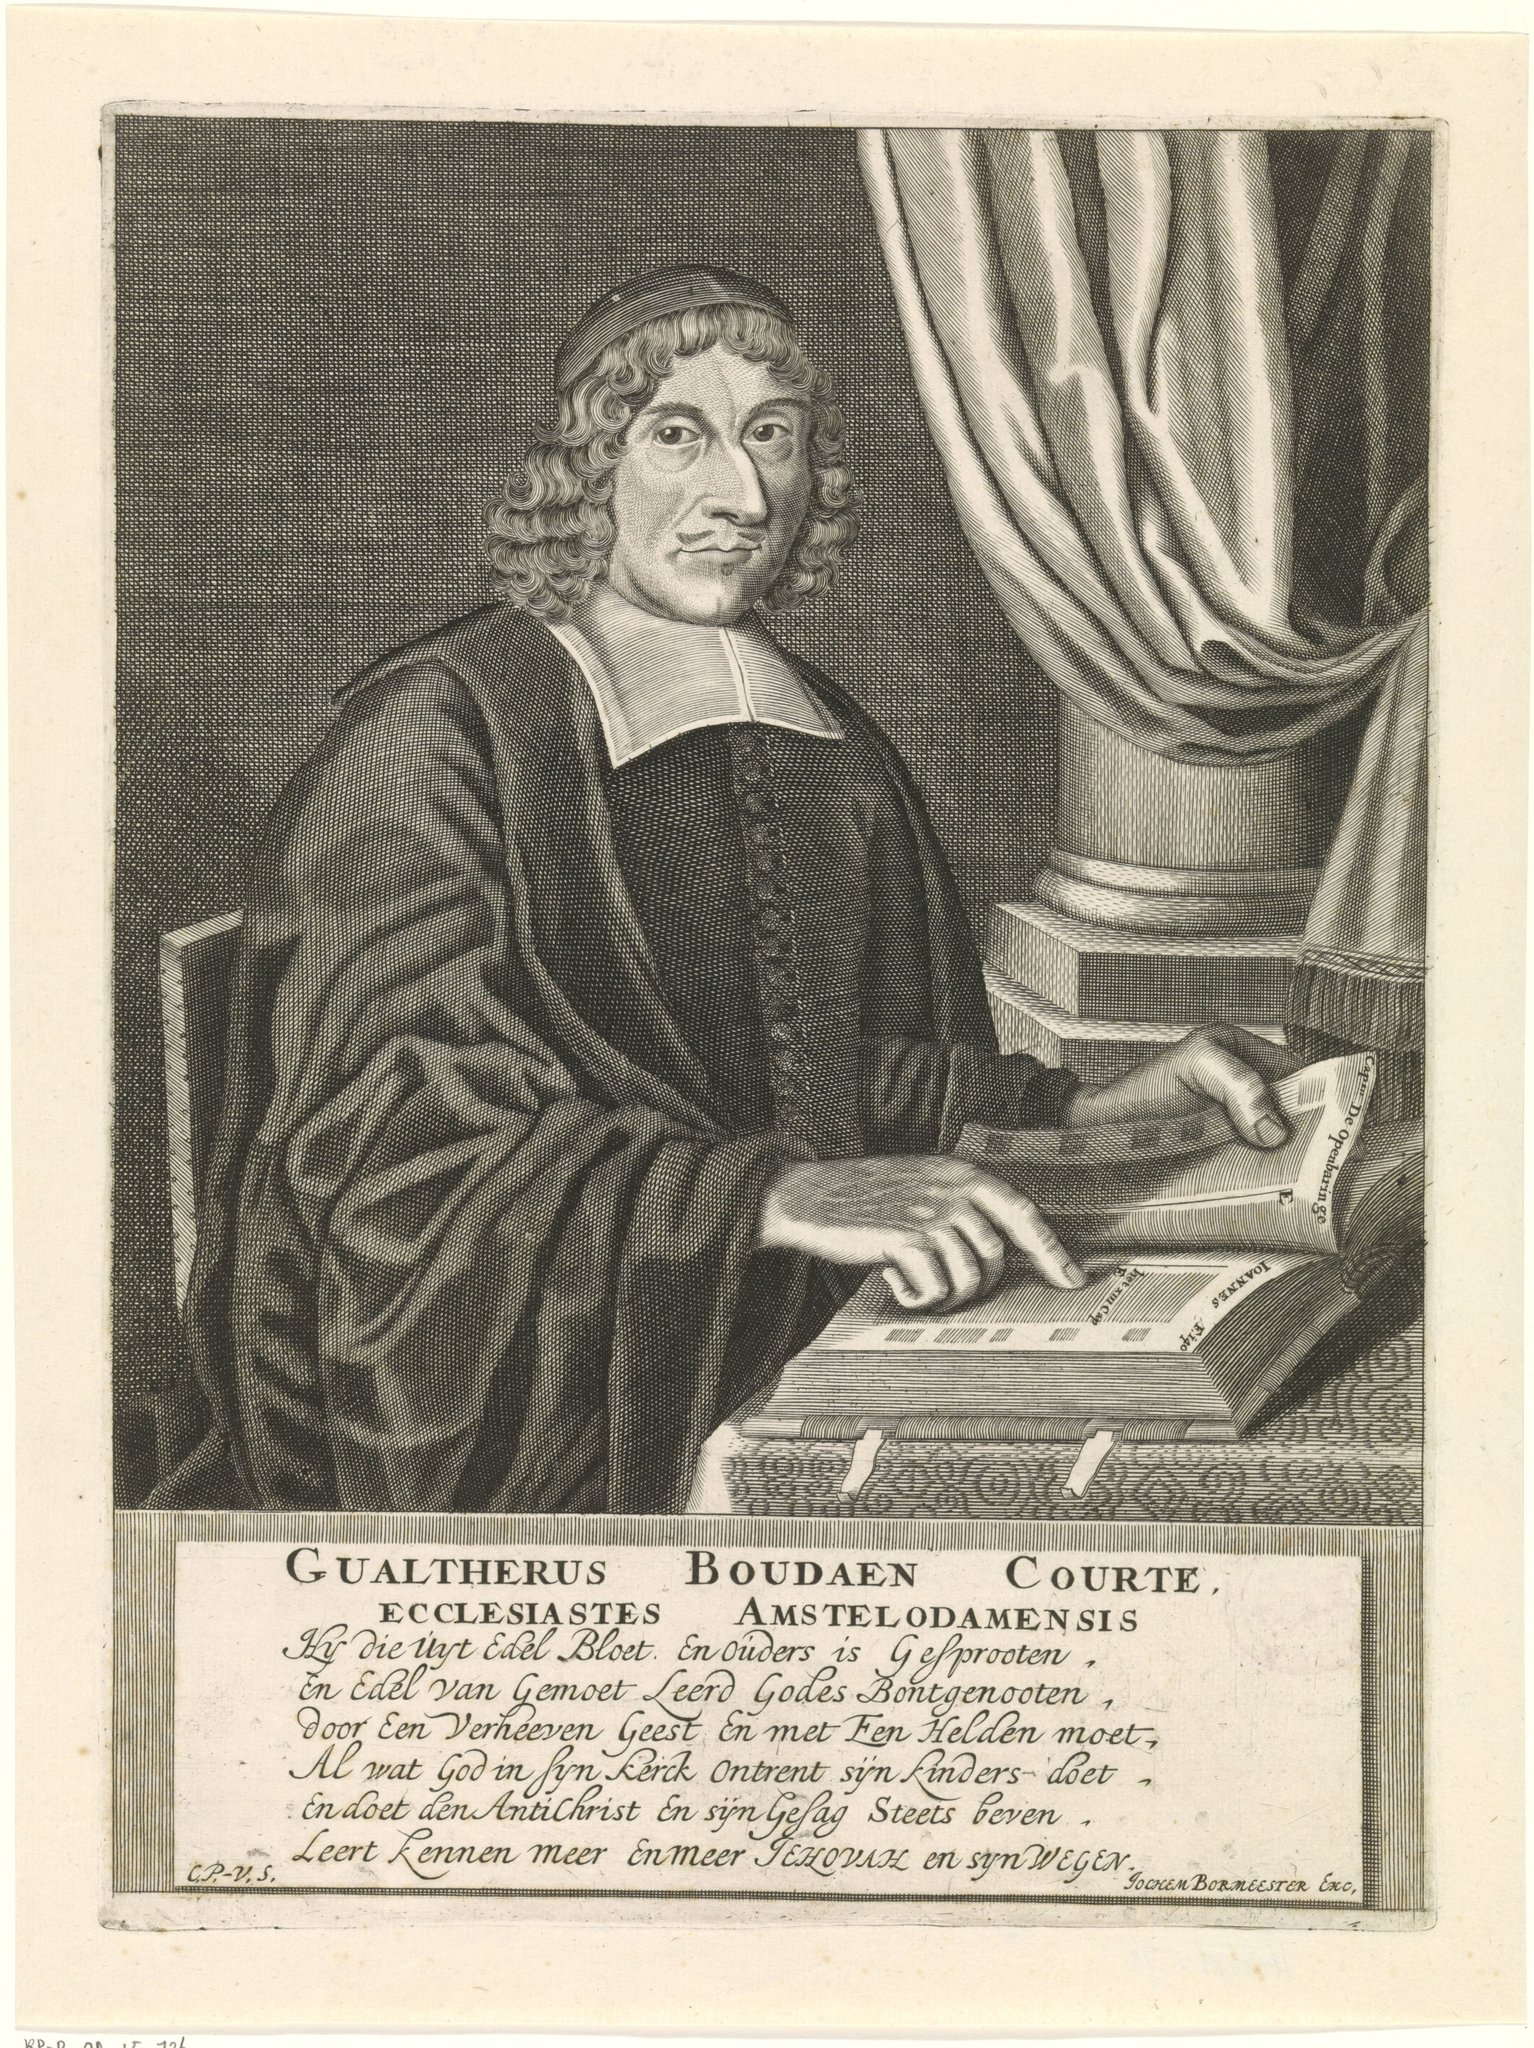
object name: print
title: Portret van de predikant Gualterus Bodaan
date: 1677-1685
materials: paper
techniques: engraving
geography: amsterdam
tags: amsterdam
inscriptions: collector's mark: Lugt 240